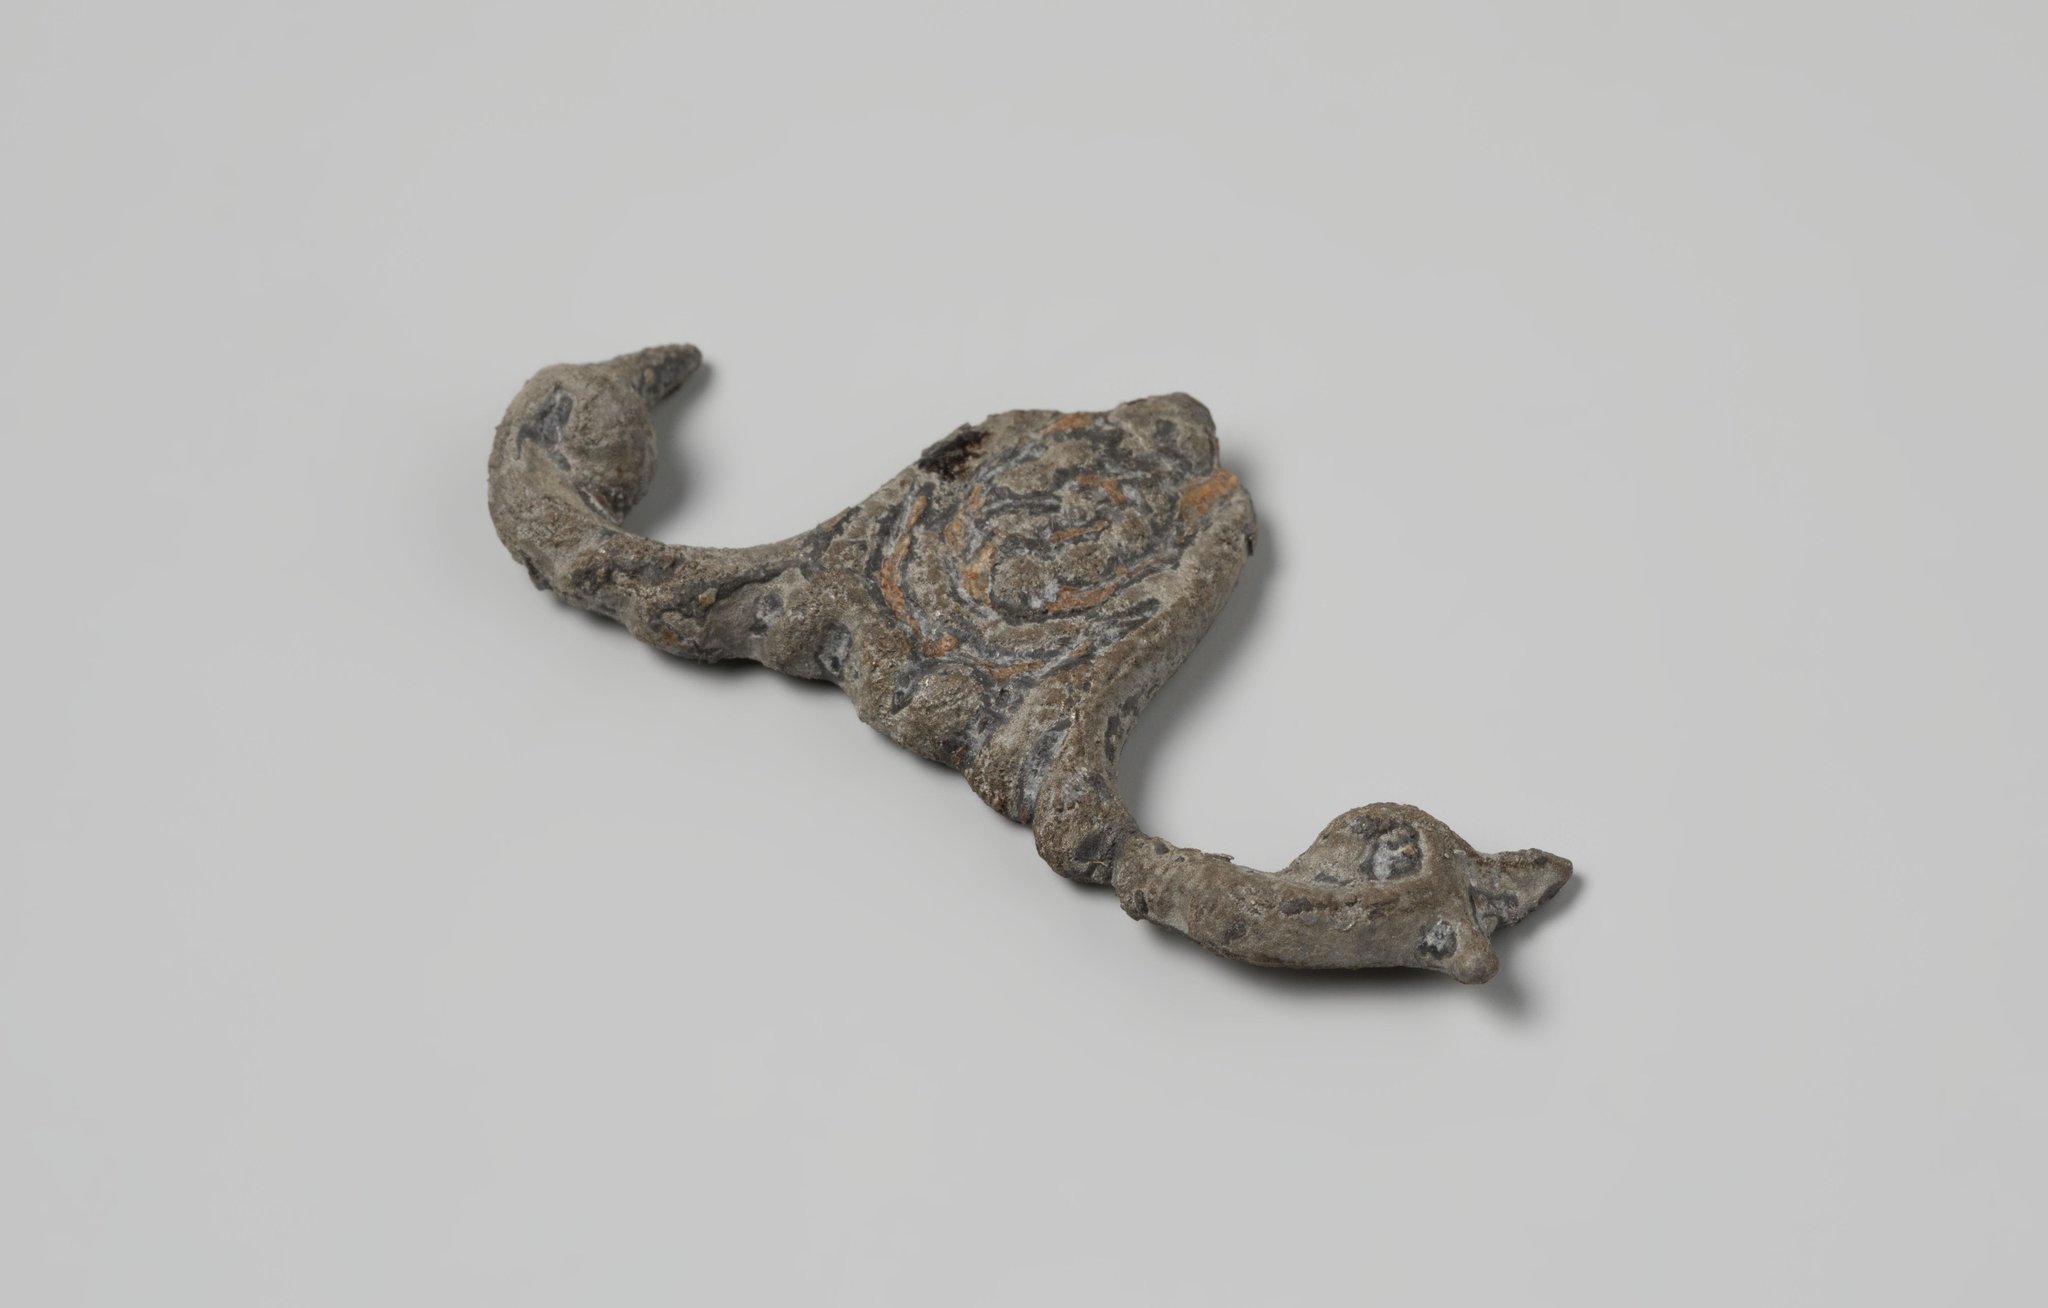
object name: beslag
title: Decoratief beslag uit het wrak van de Oost-Indiëvaarder Hollandia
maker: Anonymous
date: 1700-1743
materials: lead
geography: netherlands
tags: verenigde oostindische compagnie, hollandia (schip), annet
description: Fitting, decorative fitting or fragment; fragm, id. NG 1980-27H1133, central excutcheon, eroded.